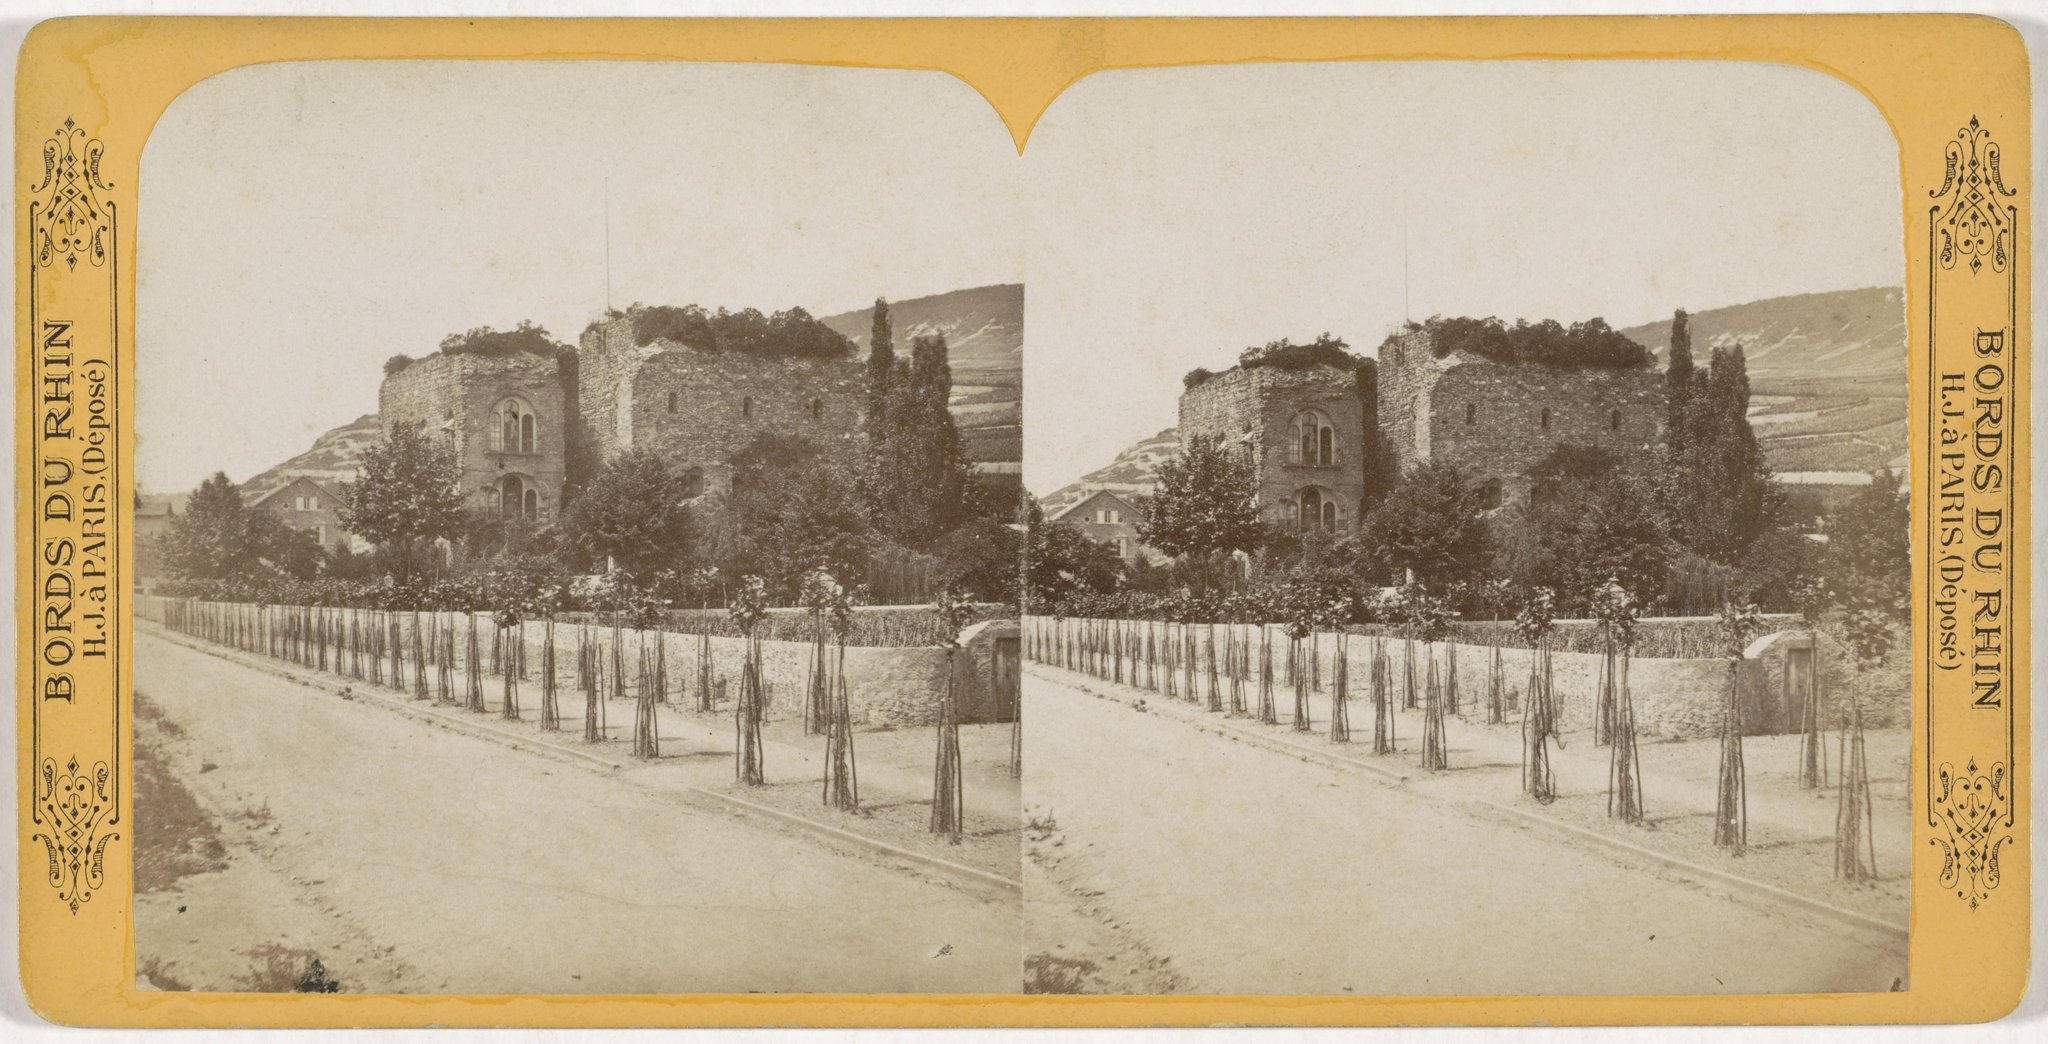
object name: stereograph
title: Ruines de Broemserburg, à Rüdesheim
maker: hippolyte jouvin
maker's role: fotograaf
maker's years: 1825-1889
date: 1860-1870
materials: cardboard, paper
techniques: albumen print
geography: rüdesheim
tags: ruin of a dwelling, house, castle, etc.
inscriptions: number: ‘N. 447’, inscription: ‘(Déposé)’, inscription: ‘Déposé.’